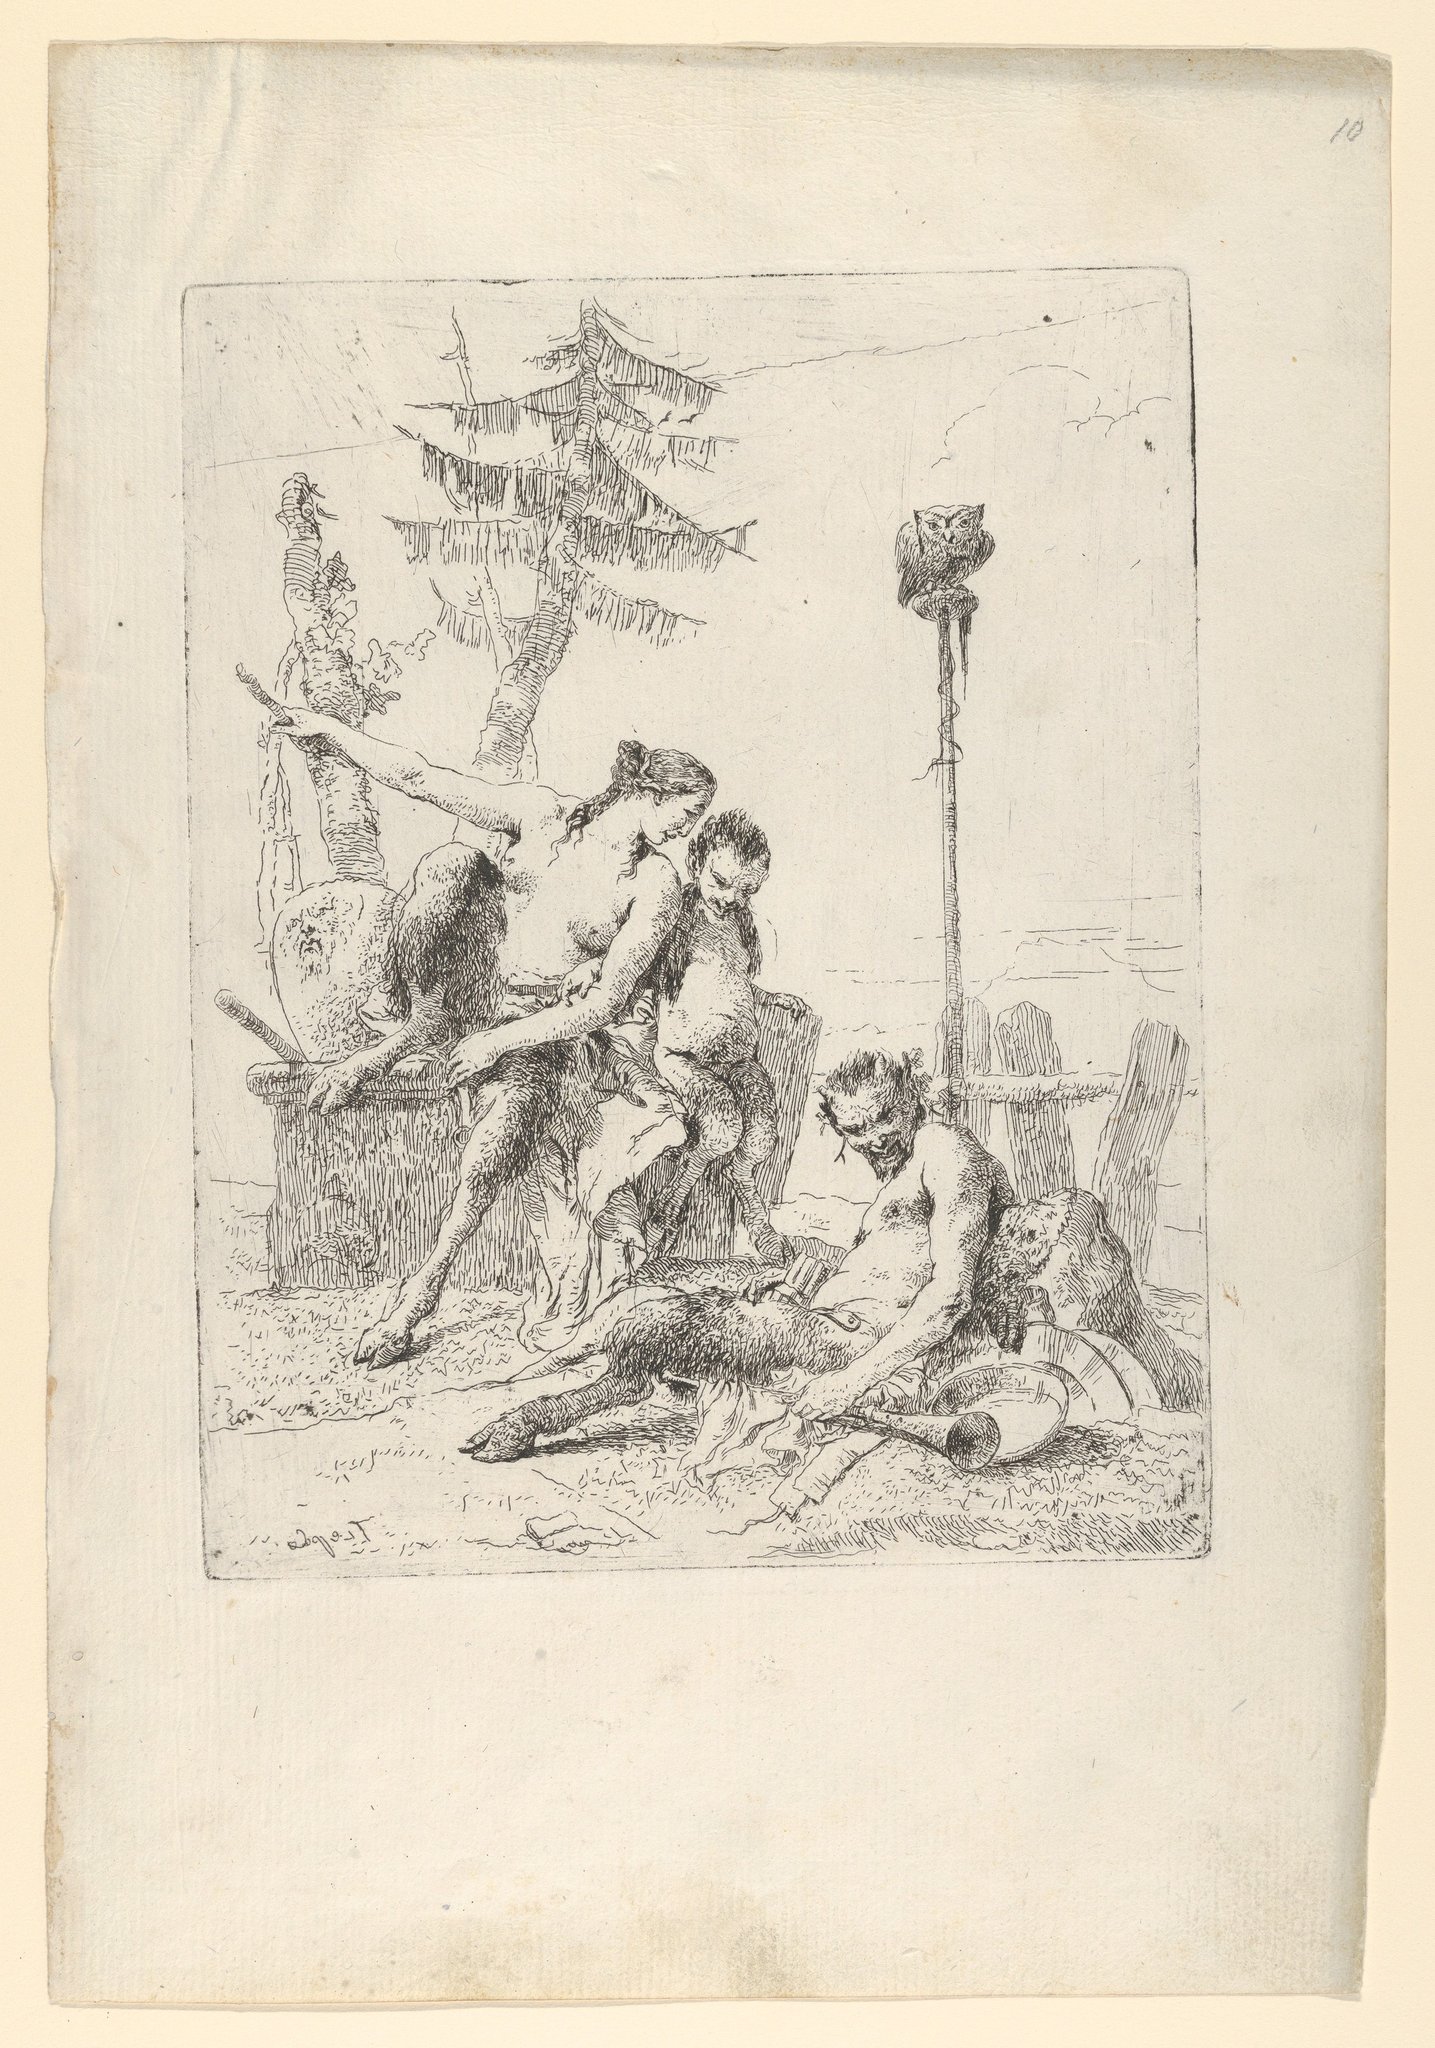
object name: print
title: Satyr Family (Pan and his Family), from the Scherzi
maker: giovanni battista tiepolo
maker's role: artist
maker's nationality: italian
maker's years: 1696-1770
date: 1743-1750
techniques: etching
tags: satyrs,owls,pan